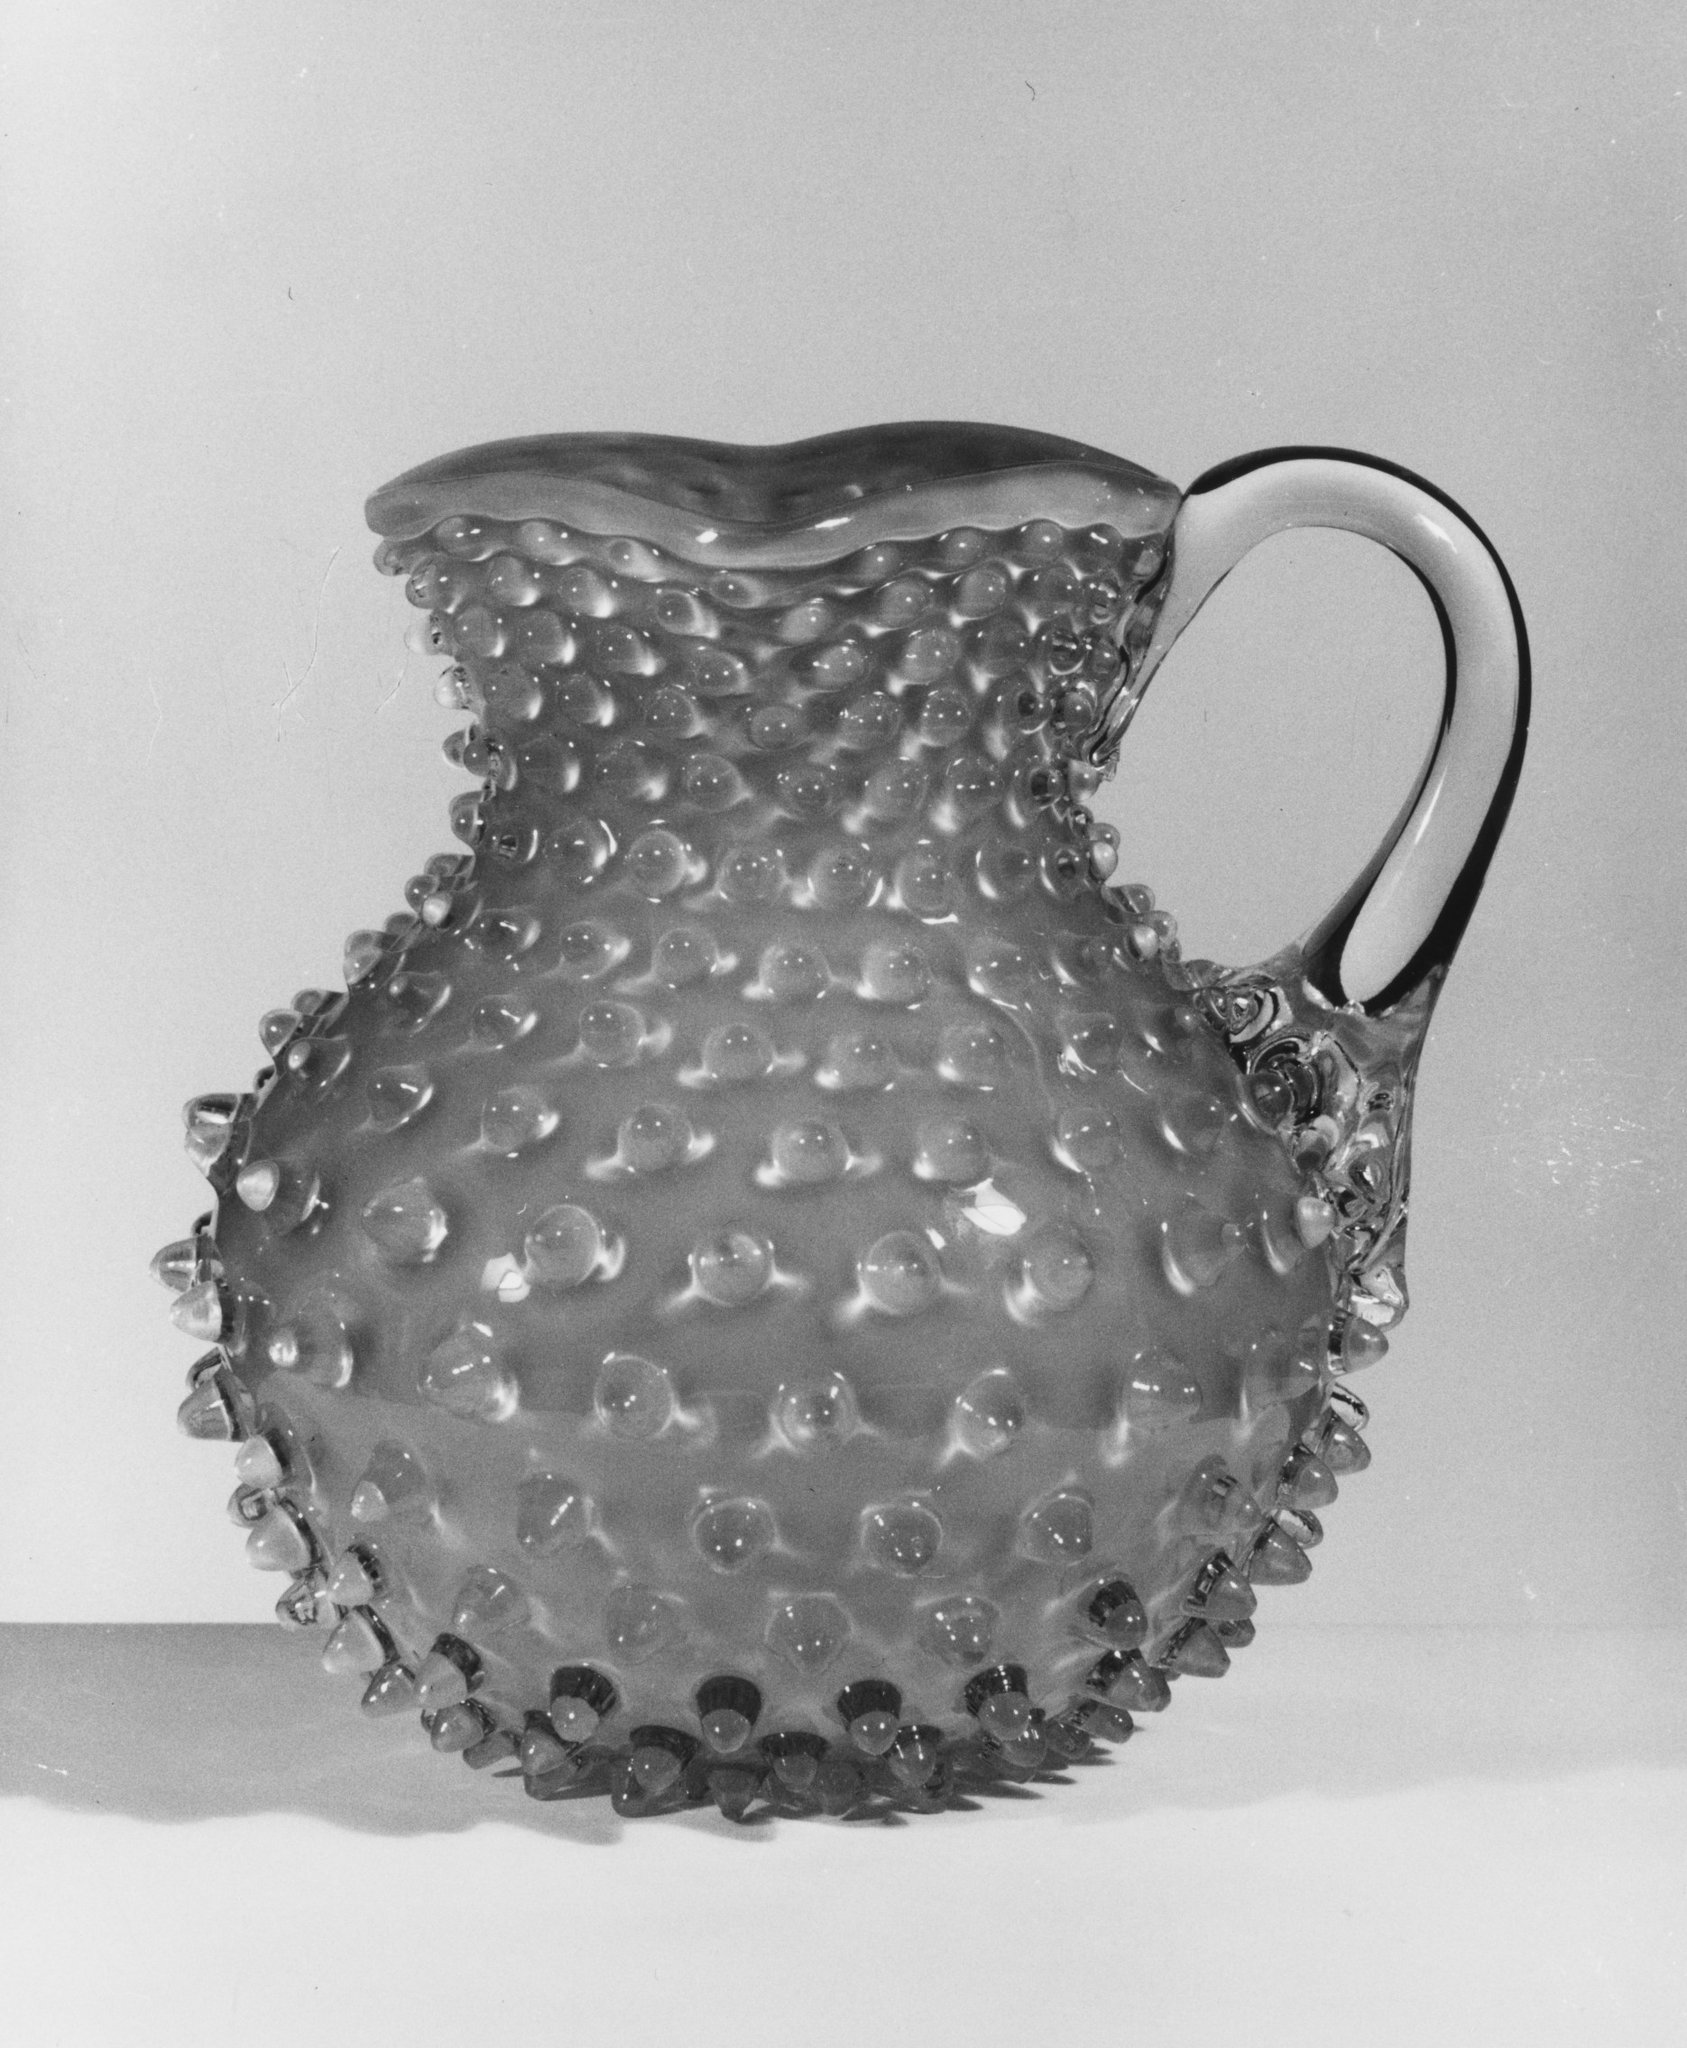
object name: pitcher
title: Hobnail pitcher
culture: american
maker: hobbs, brockunier and company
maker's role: maker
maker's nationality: american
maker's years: 1863-1891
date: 1886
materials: glass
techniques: pressed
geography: united states